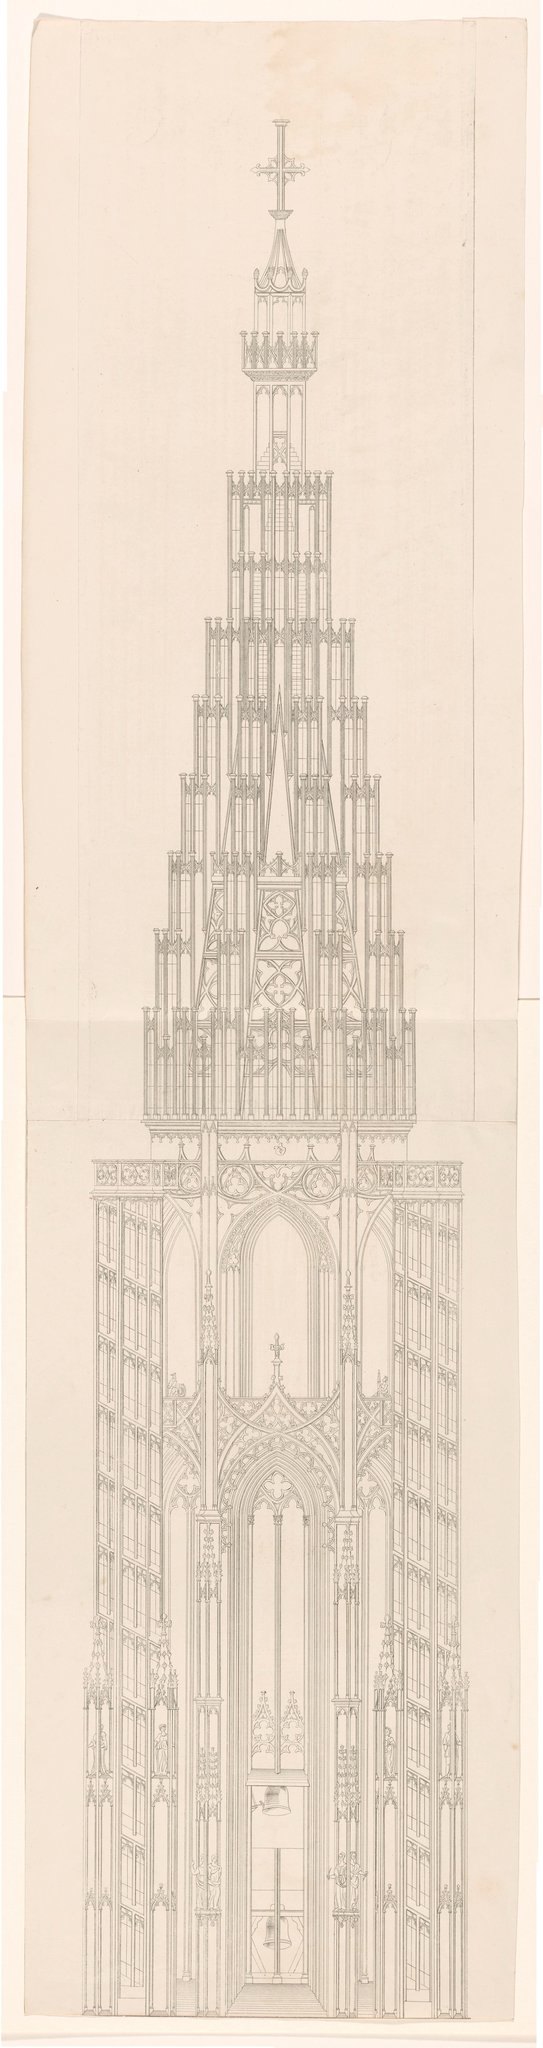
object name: print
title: Gezicht op de toren van de kathedraal van Straatsburg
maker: Anonymous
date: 1839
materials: paper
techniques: etching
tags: church (exterior)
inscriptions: collector's mark: Lugt 2228